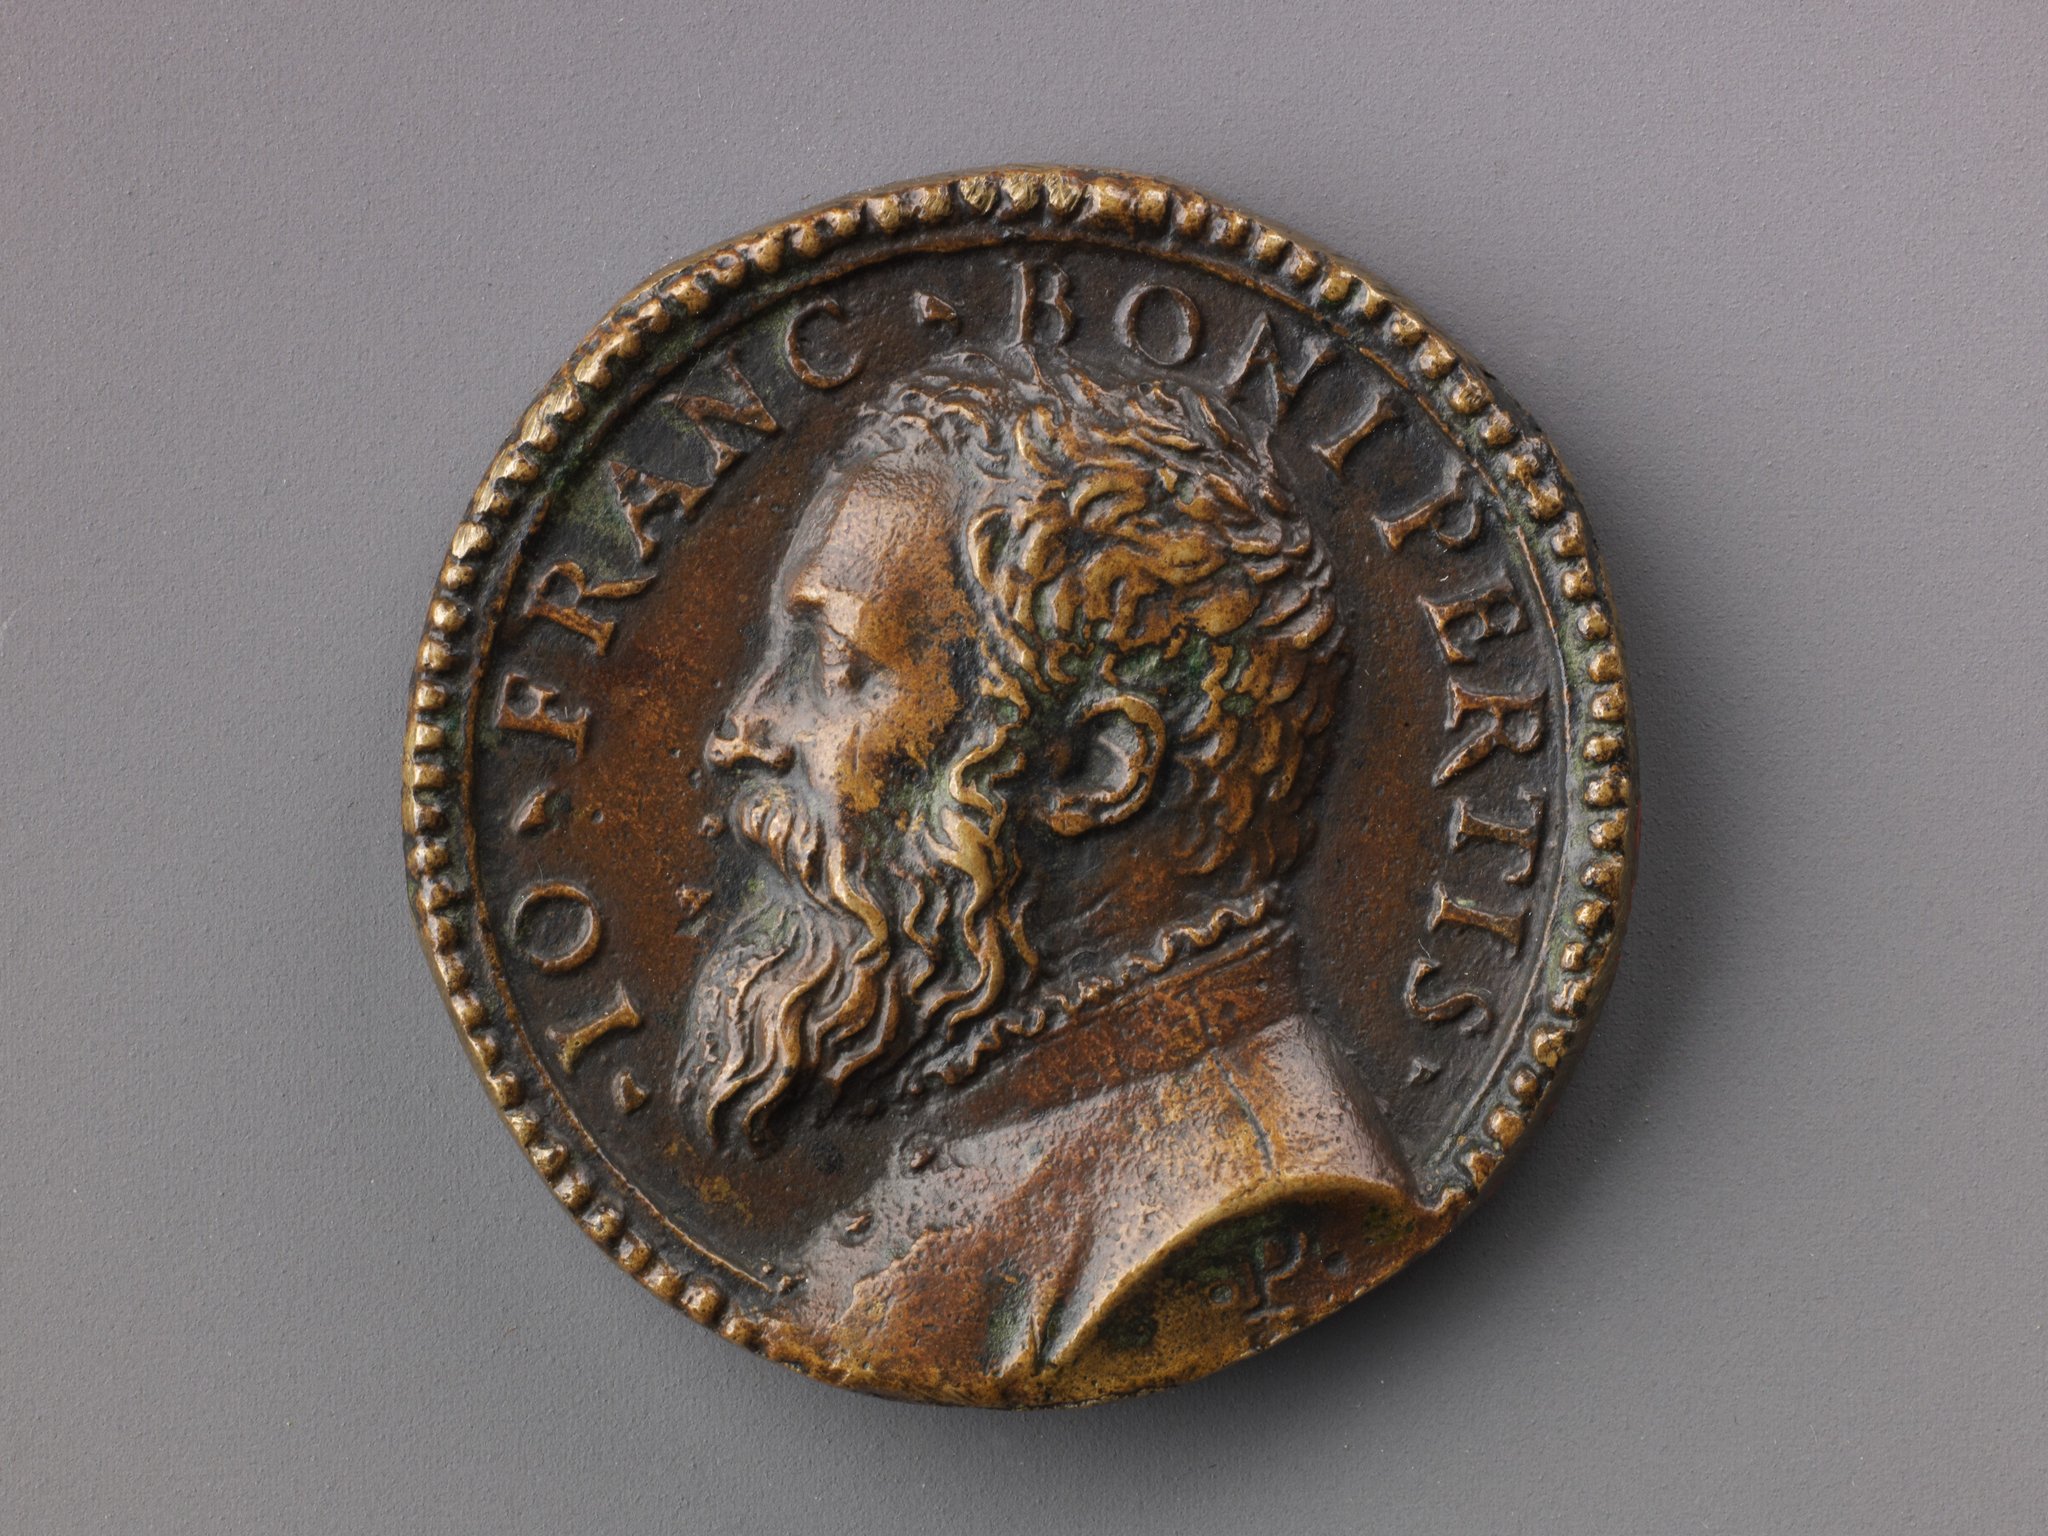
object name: medal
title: Medal: Bust of Gianfrancesco Boniperti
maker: pastorino de pastorini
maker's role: artist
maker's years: 1508-1592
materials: bronze, copper alloy, patina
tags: men,portraits,profiles